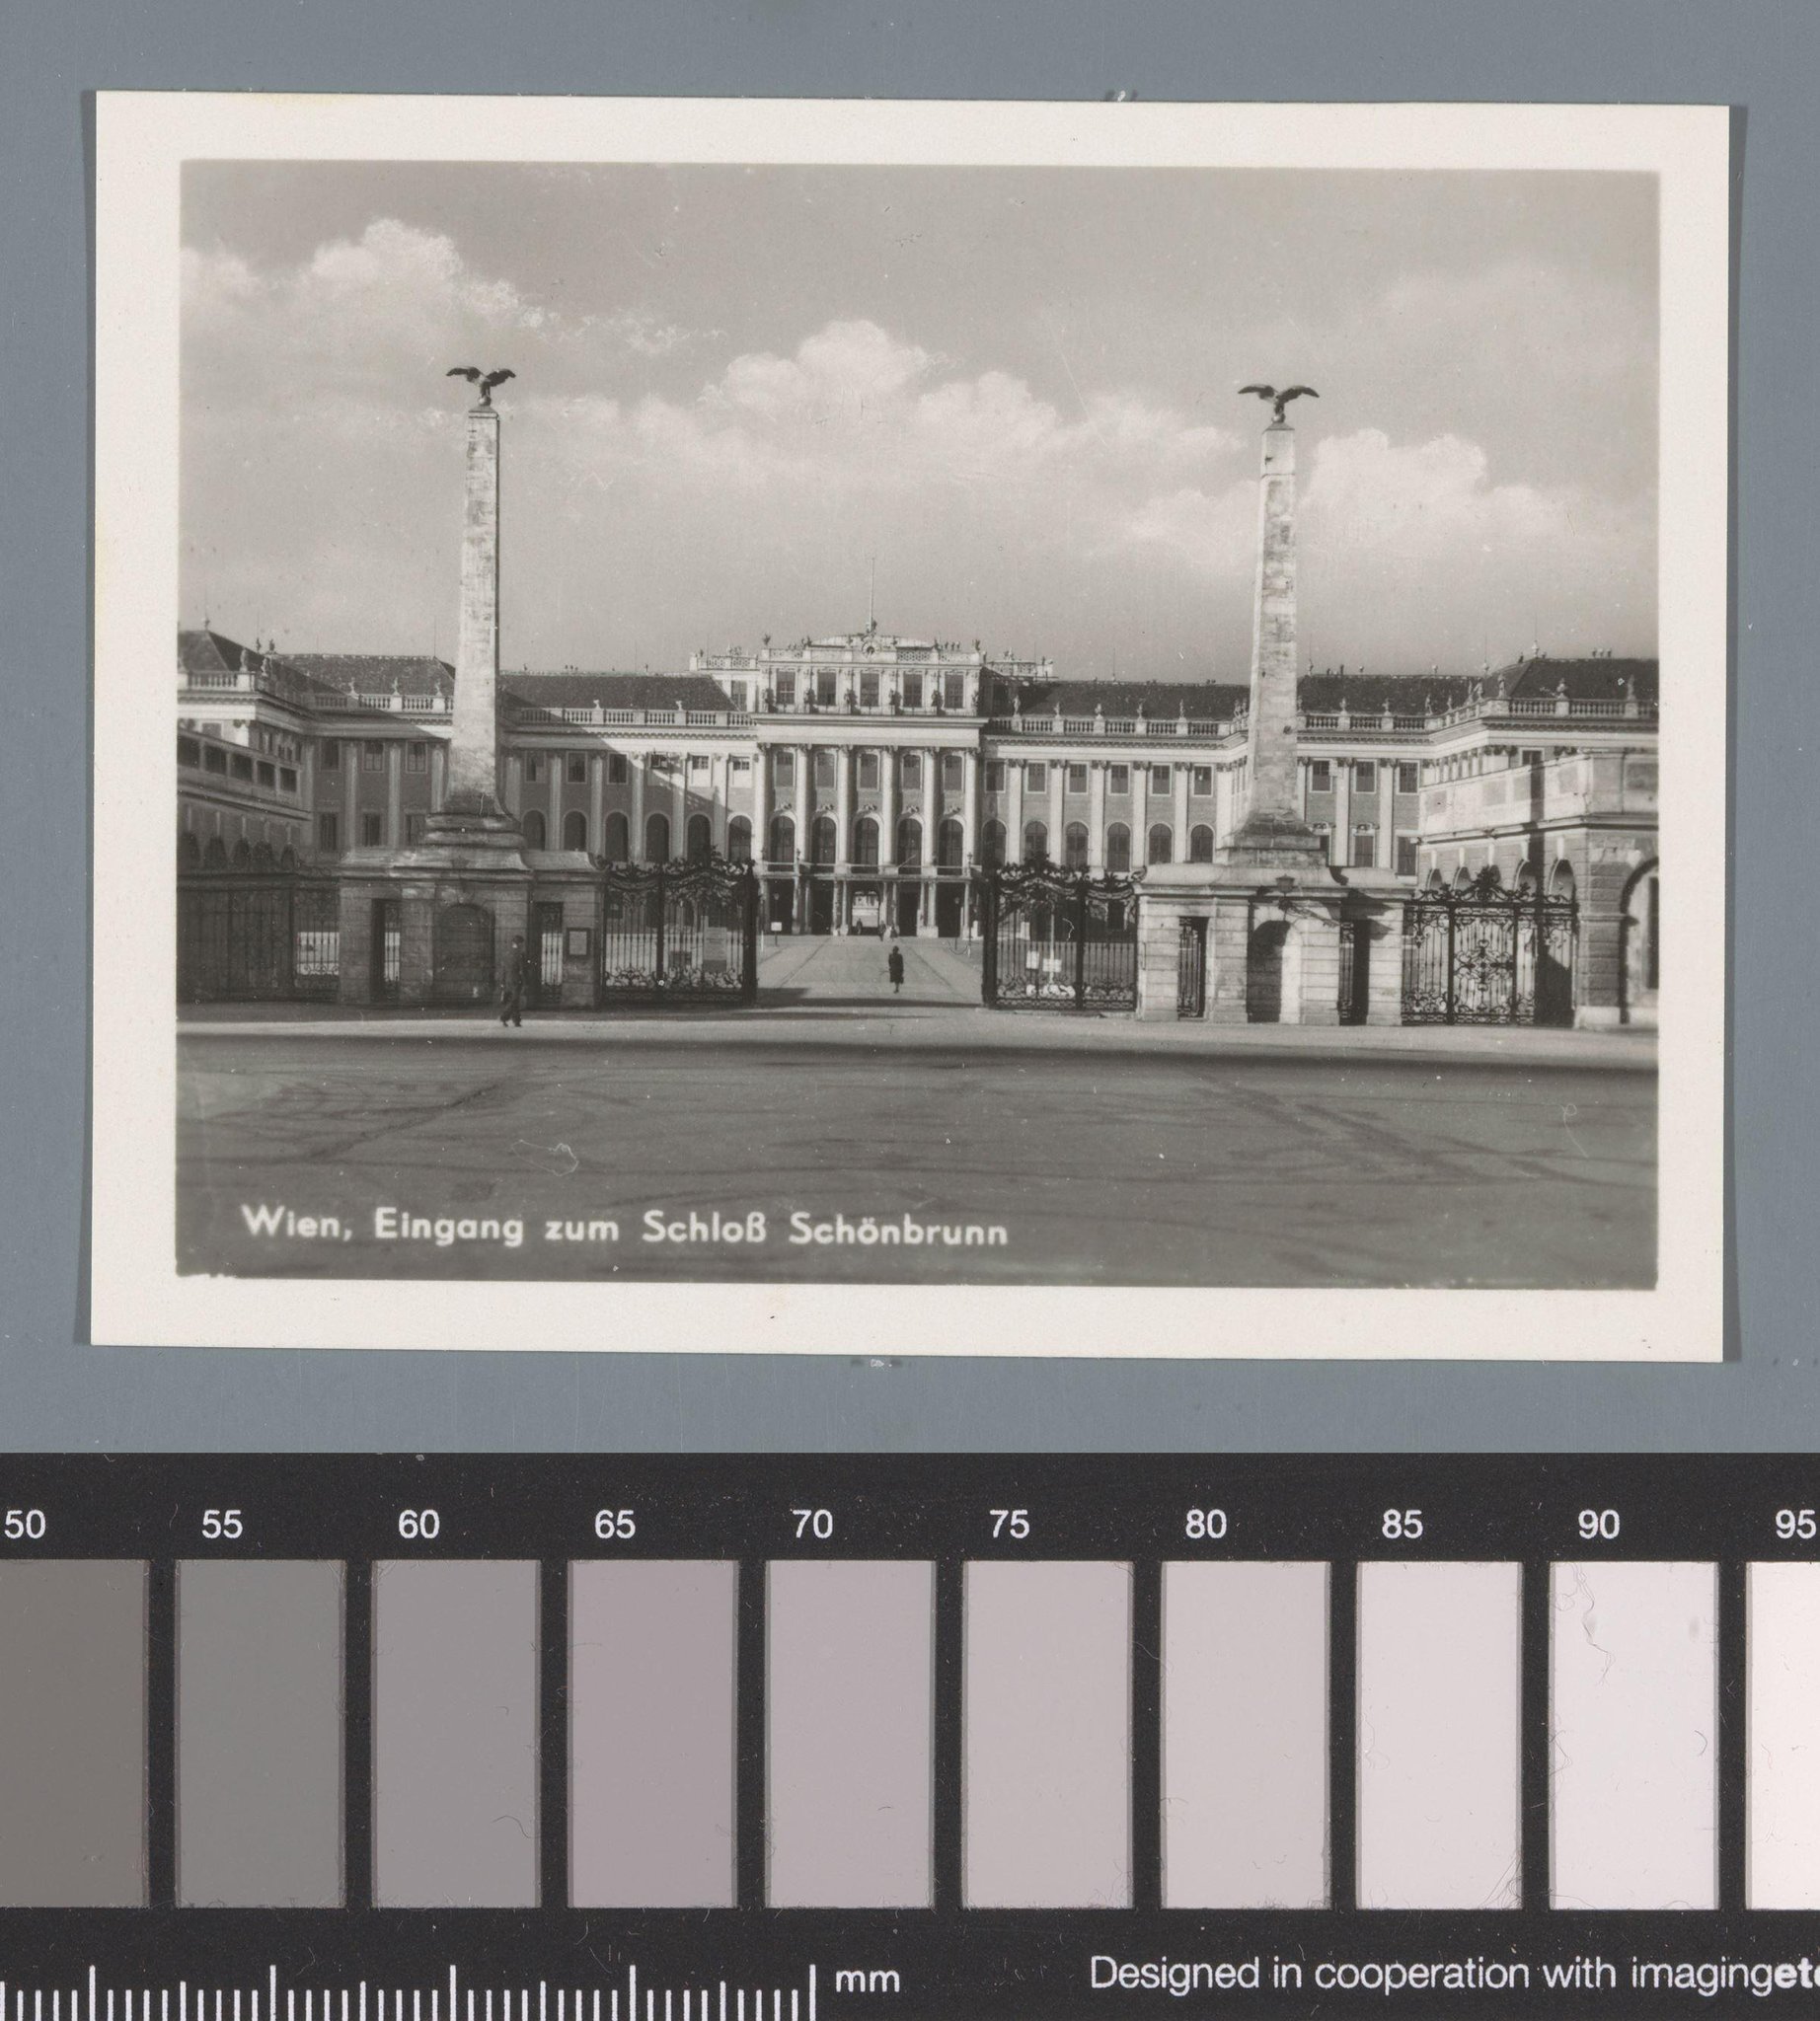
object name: photograph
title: Wien, Eingang zum Schloß Schönbrunn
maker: Anonymous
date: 1950-1960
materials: photographic support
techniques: gelatin silver print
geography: vienna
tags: palace, gate, entrance